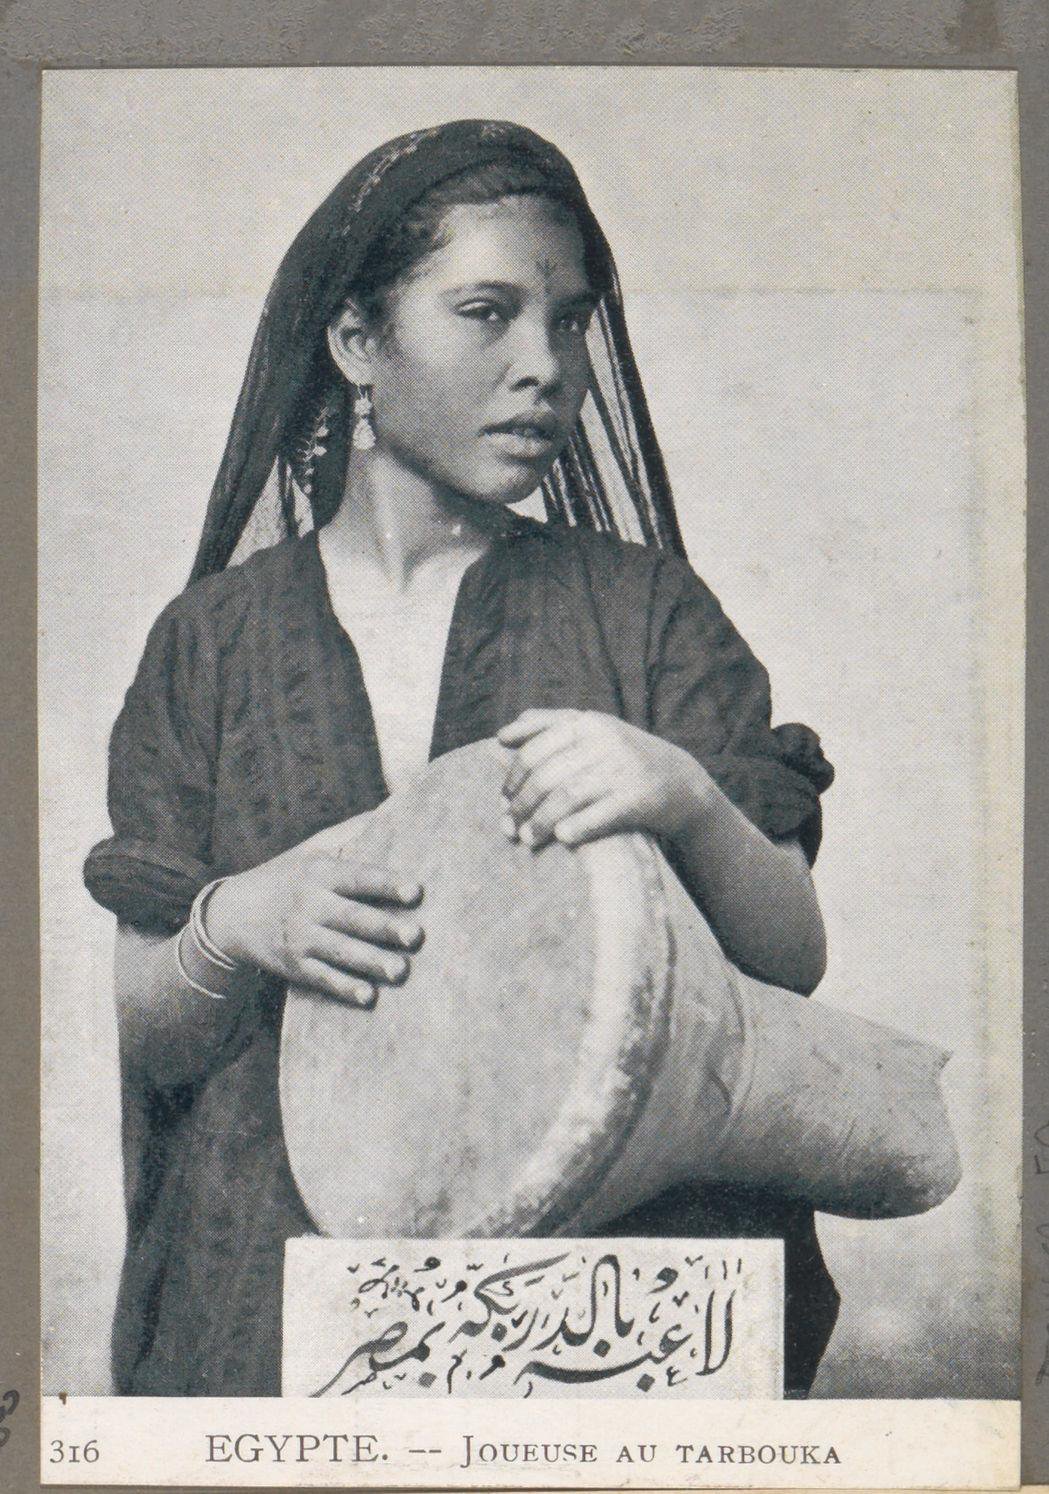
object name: ansichtkaart, prentbriefkaart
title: Portret van een Egyptische vrouw met een darboeka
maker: Anonymous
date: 1895-1905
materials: paper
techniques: autotype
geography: egypt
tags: portrait of a musician, drum (musical instrument)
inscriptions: number: ‘316’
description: Onderdeel van Reisalbum met foto's van bezienswaardigheden in Griekenland en Egypte.